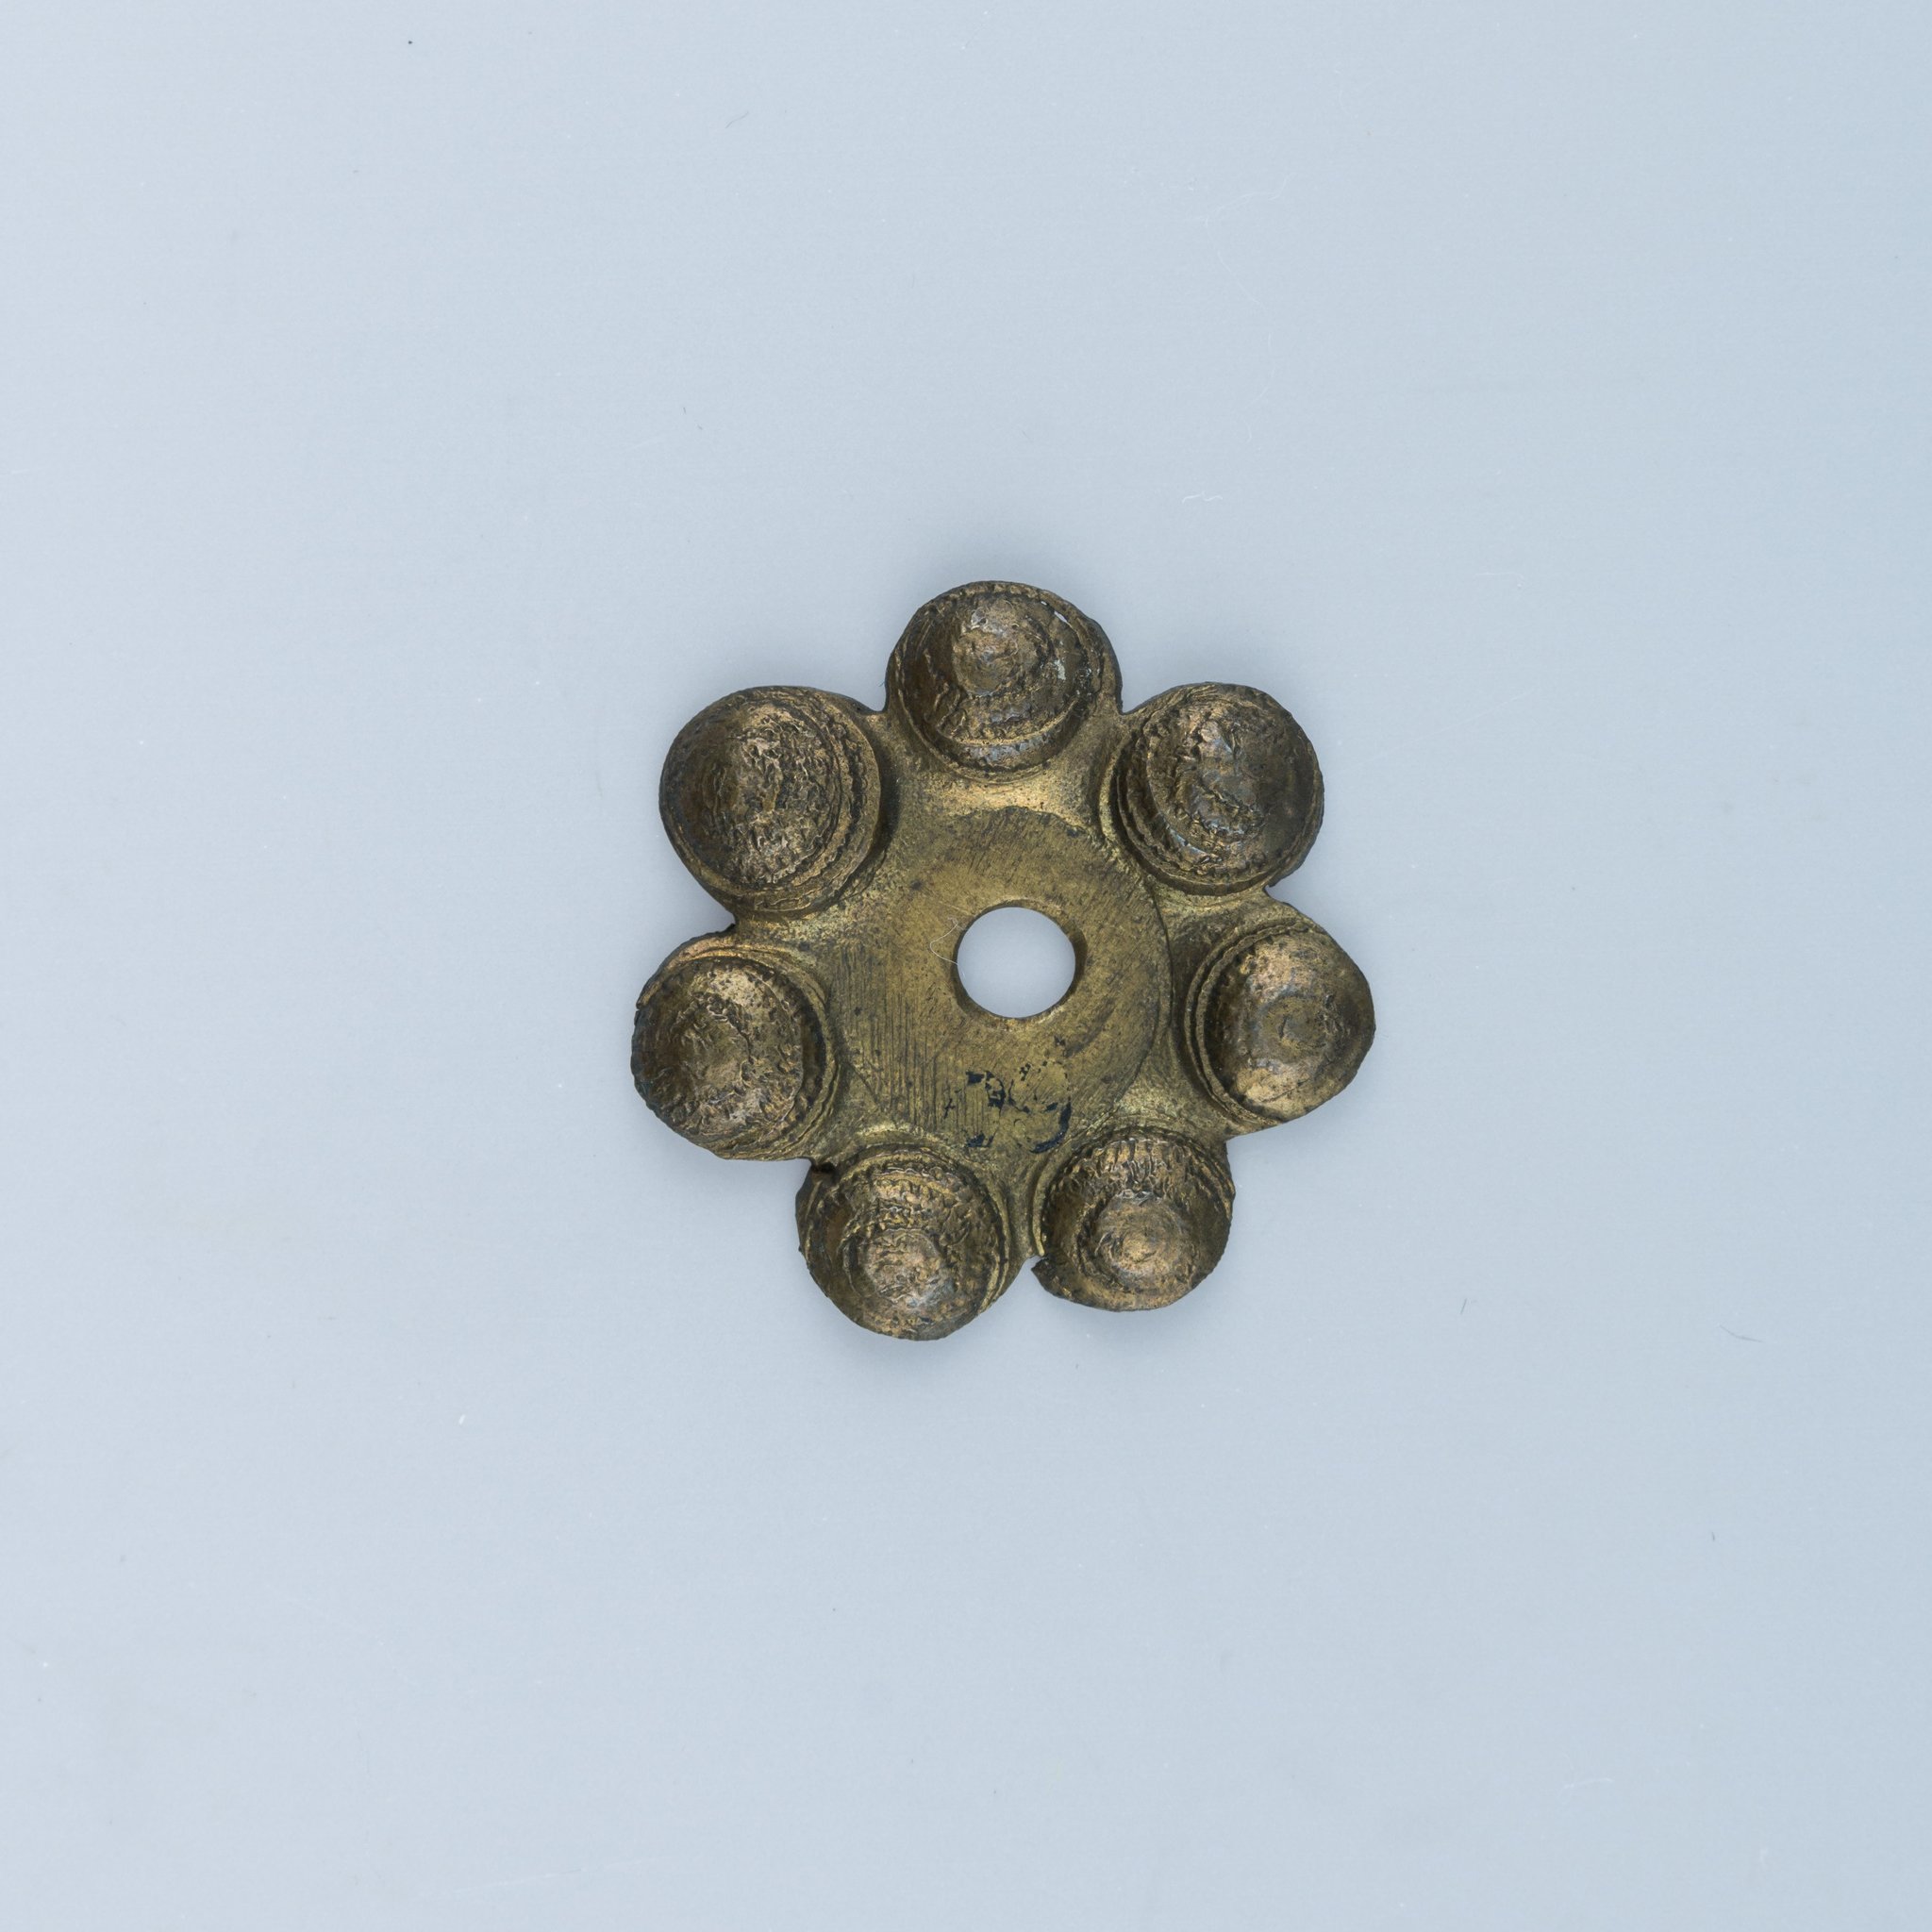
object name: rosette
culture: french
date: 1540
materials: brass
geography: france